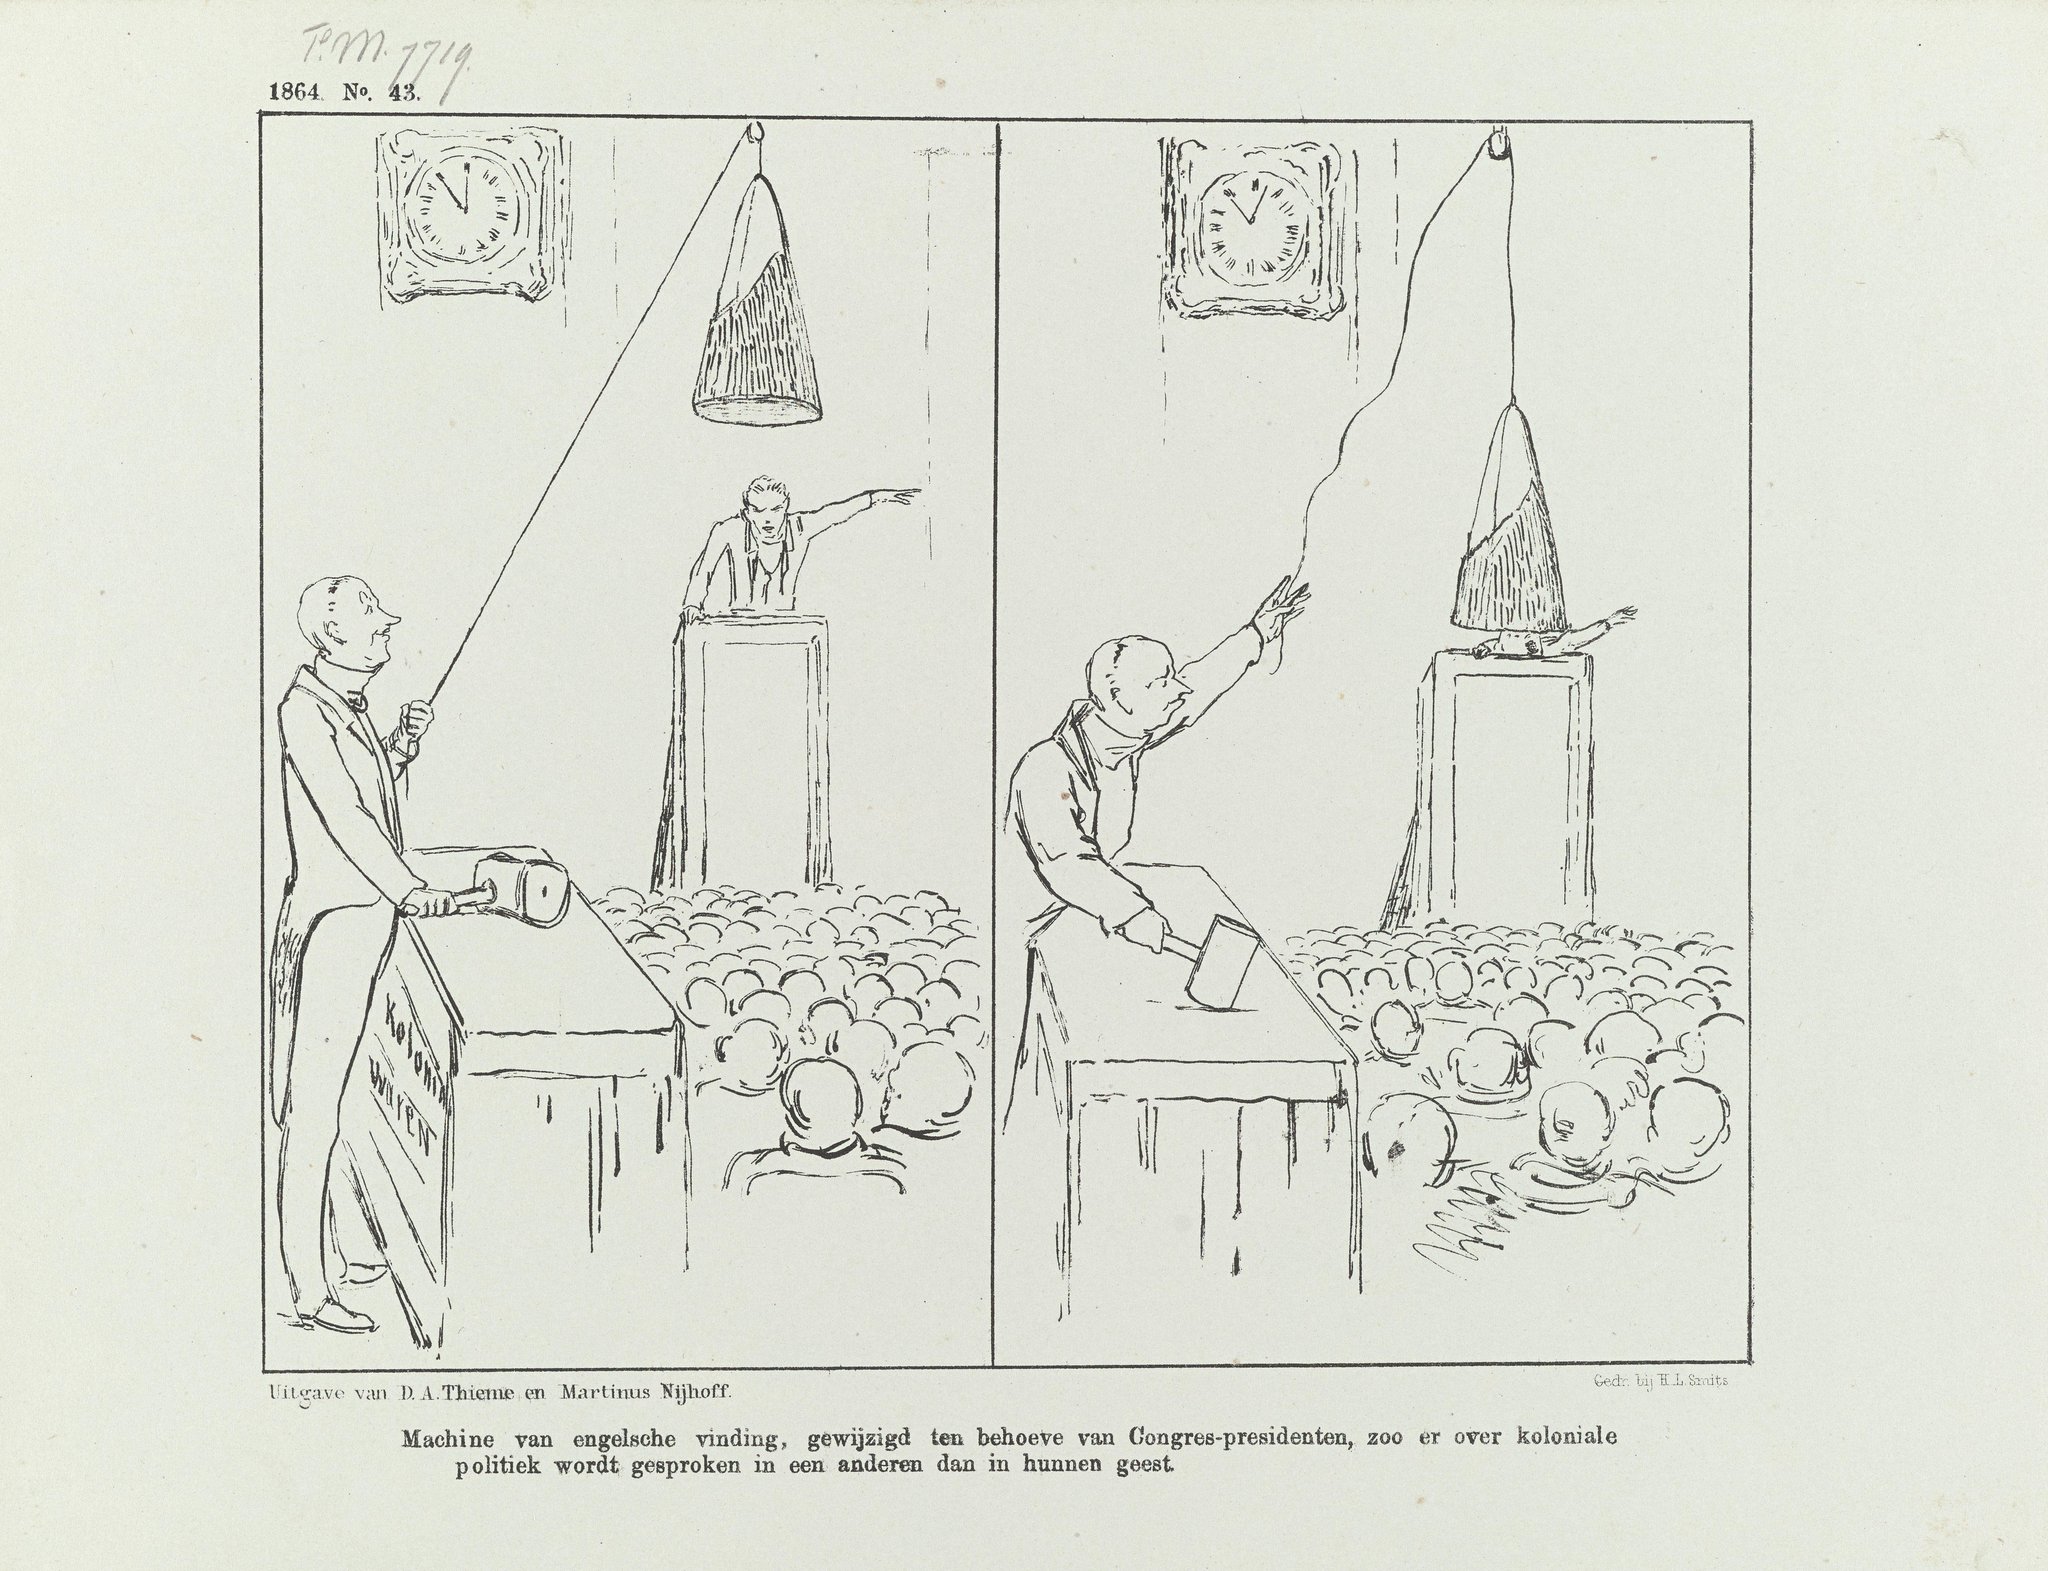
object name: print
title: Machine van engelsche vinding, gewijzigd ten behoeve van Congres-presidenten, zoo er over koloniale politiek wordt gesproken in een anderen dan in hunnen geest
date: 1864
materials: paper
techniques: lithograph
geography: arnhem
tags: meeting, assembly, loaf-sugar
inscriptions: collector's mark: Lugt 2228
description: Spotprent op Jhr Hartsen als president van de vierde sectie op het congres ter bevordering van sociale wetenschappen te Amsterdam over koloniale politiek. De president kan een suikerbrood op de spreker laten zakken wanneer zijn diens toon hem niet bevalt. Plaat verschenen bij het weekblad De Nederlandsche Spectator, nr. 43, 22 oktober 1864.